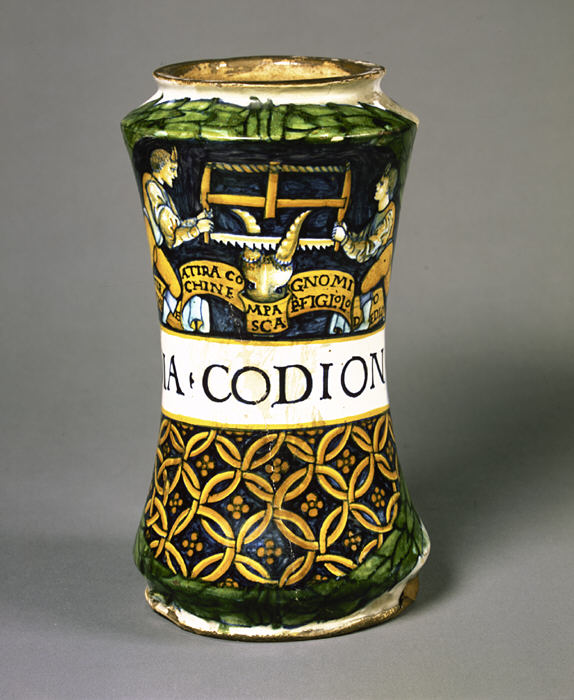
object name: albarello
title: Pharmacy Jar (albarello)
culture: italian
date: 1505-1510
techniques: maiolica, glazing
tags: men,tools